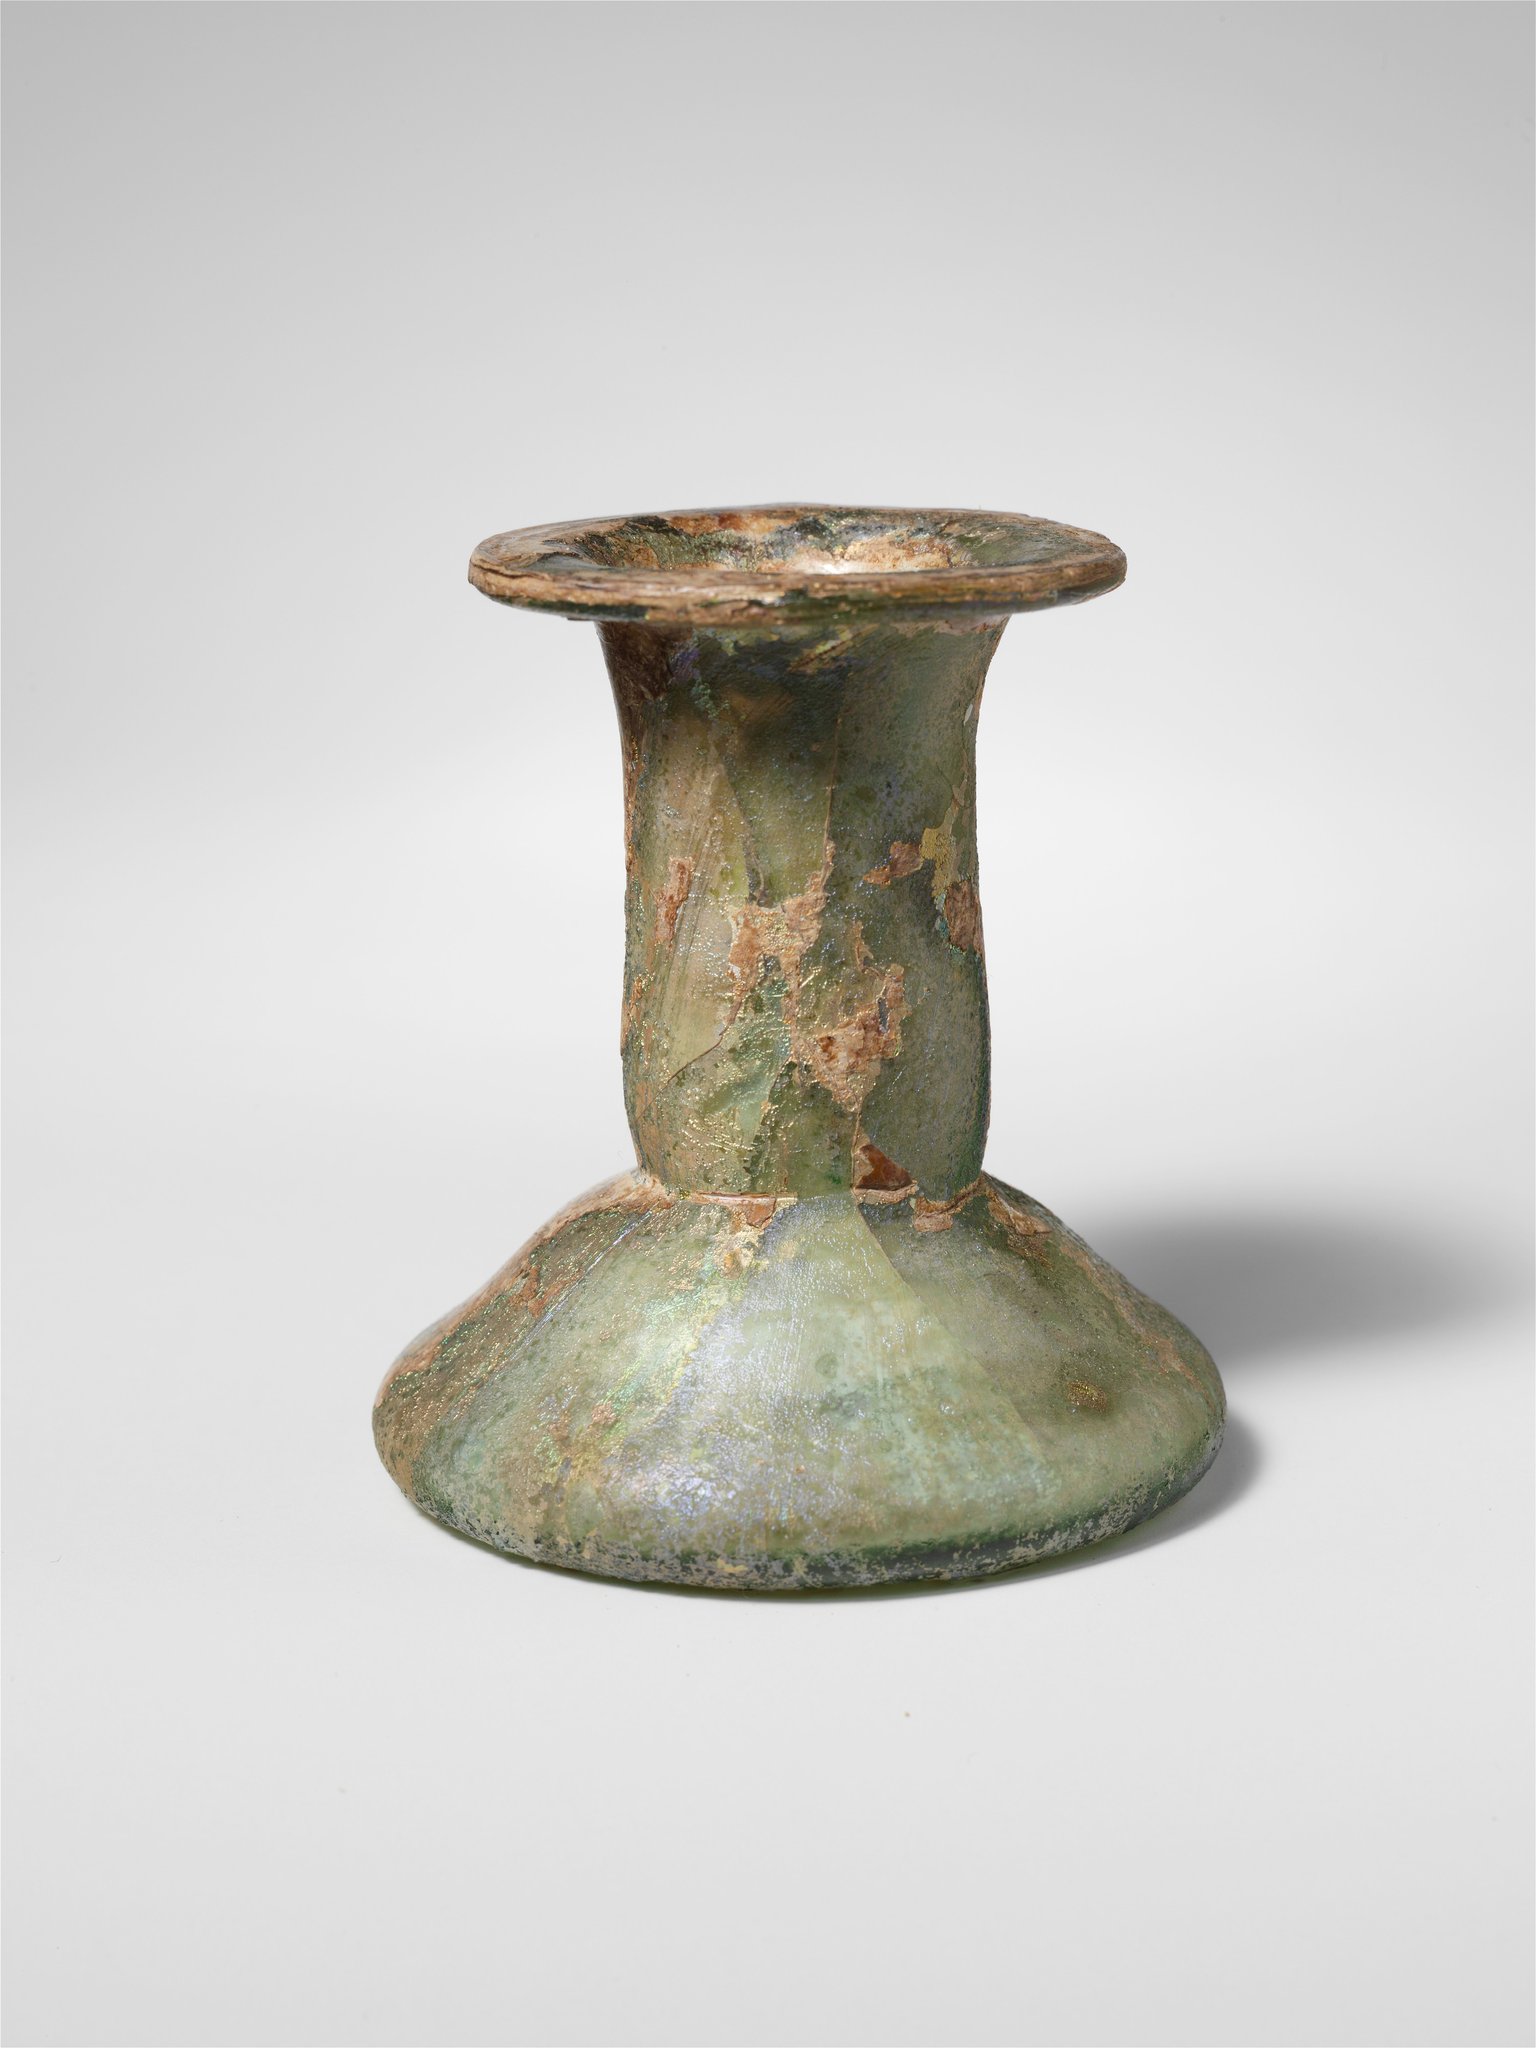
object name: perfume bottle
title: Glass perfume bottle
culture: roman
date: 101-300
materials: glass